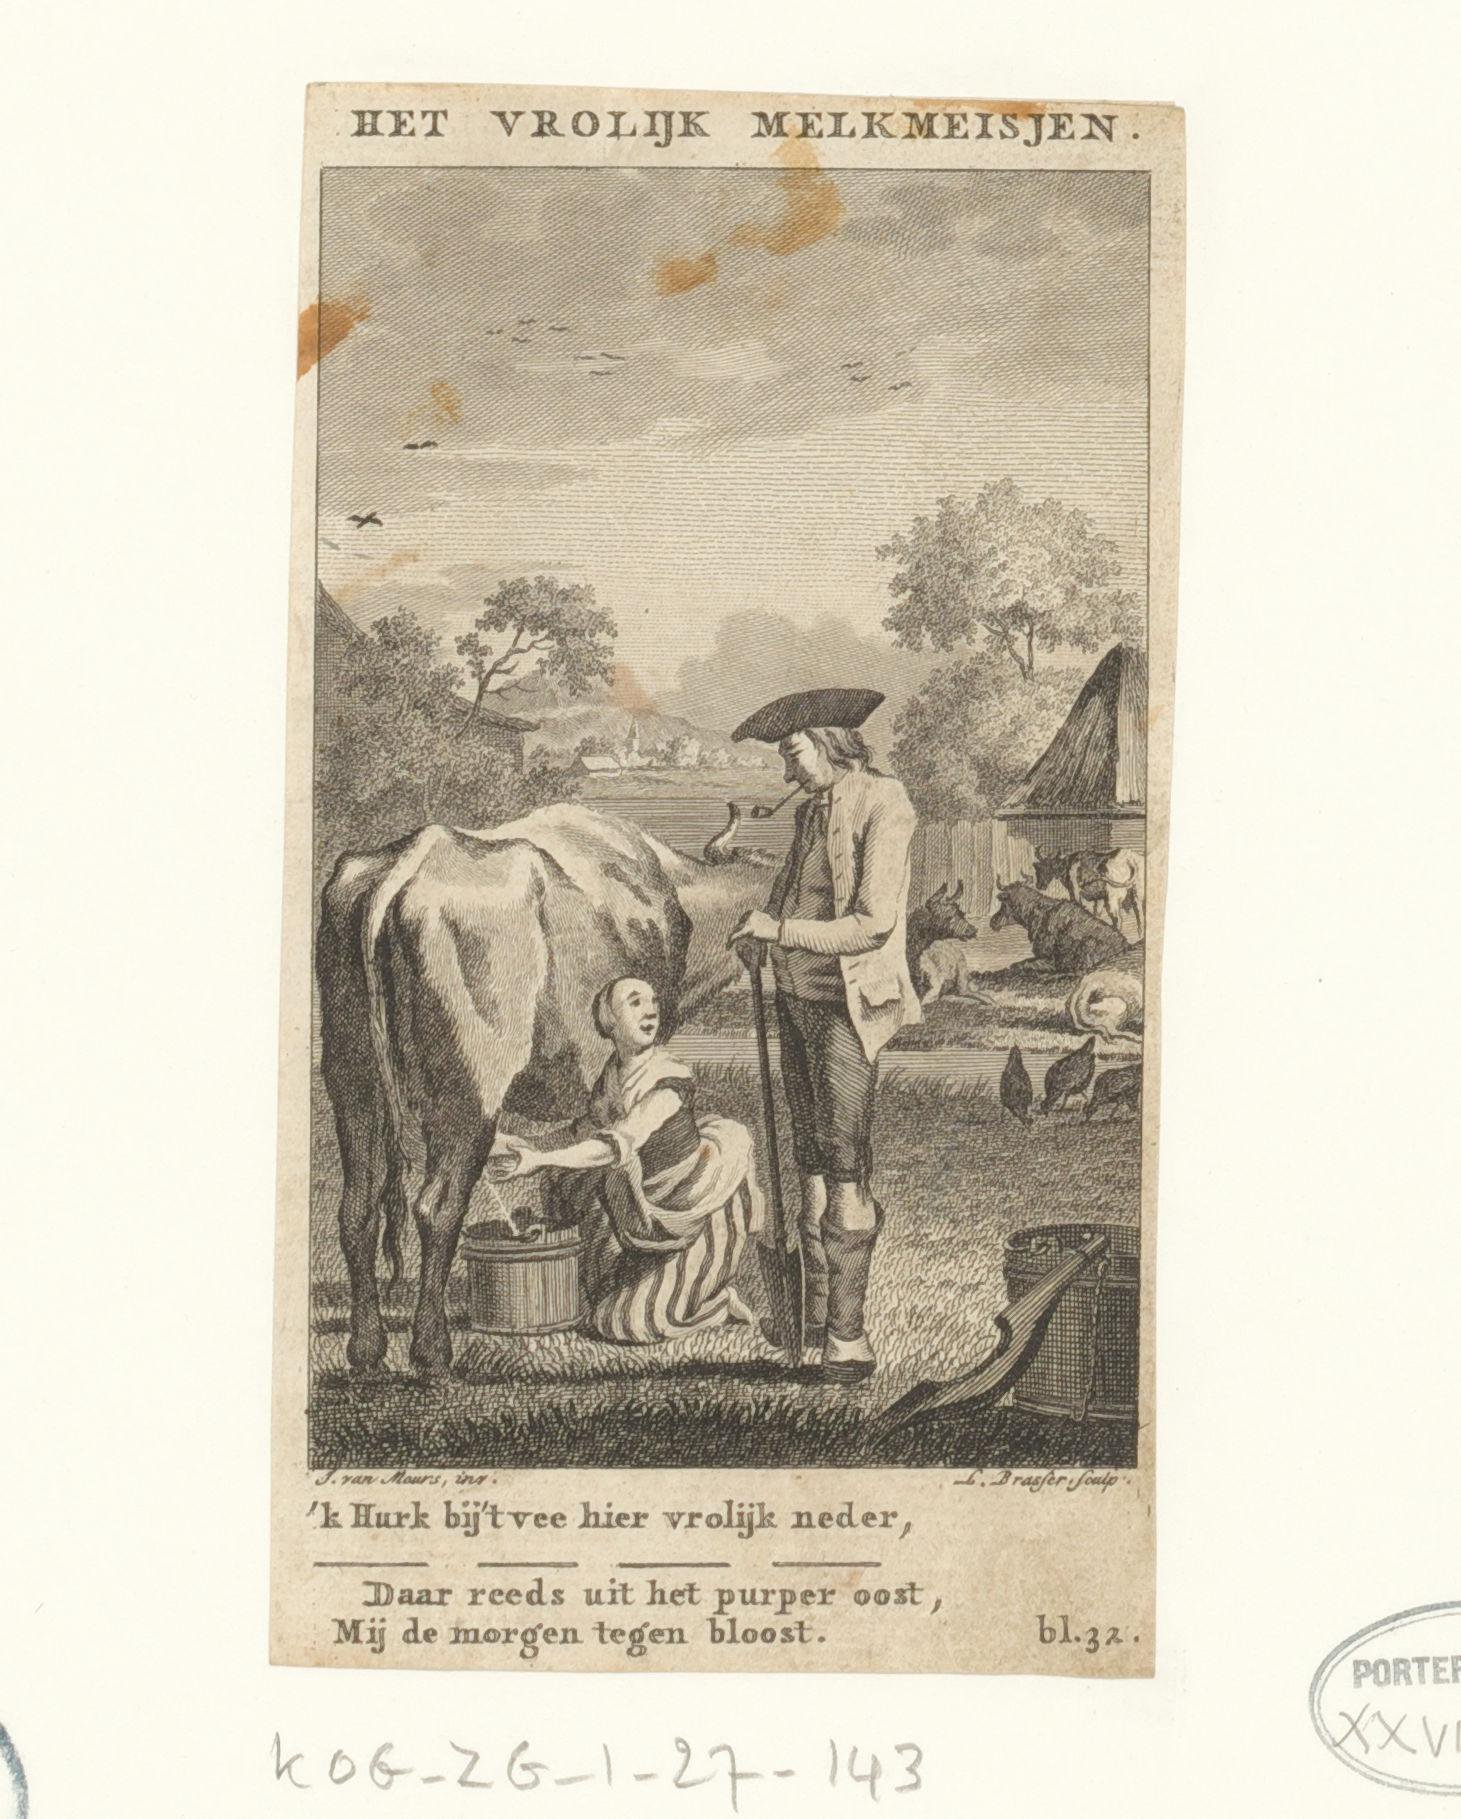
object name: book illustration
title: Het vrolijk melkmeisjen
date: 1789-1791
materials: paper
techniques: engraving, etching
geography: netherlands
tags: milkmaid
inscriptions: collector's mark: Lugt 1641, collector's mark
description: Gebruikt als illustratie in: Volks-liedjes, uitgegeven door de Maatschappij tot Nut van 't Algemeen, Amsterdam: Harmanus Keijzer, Arend Fokke en Cornelis de Vries, 3 delen, 1789-1791, p. 32/33.